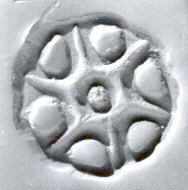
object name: stamp seal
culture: bactria-margiana archaeological complex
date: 2333-1668 BCE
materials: stone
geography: bactria-margiana